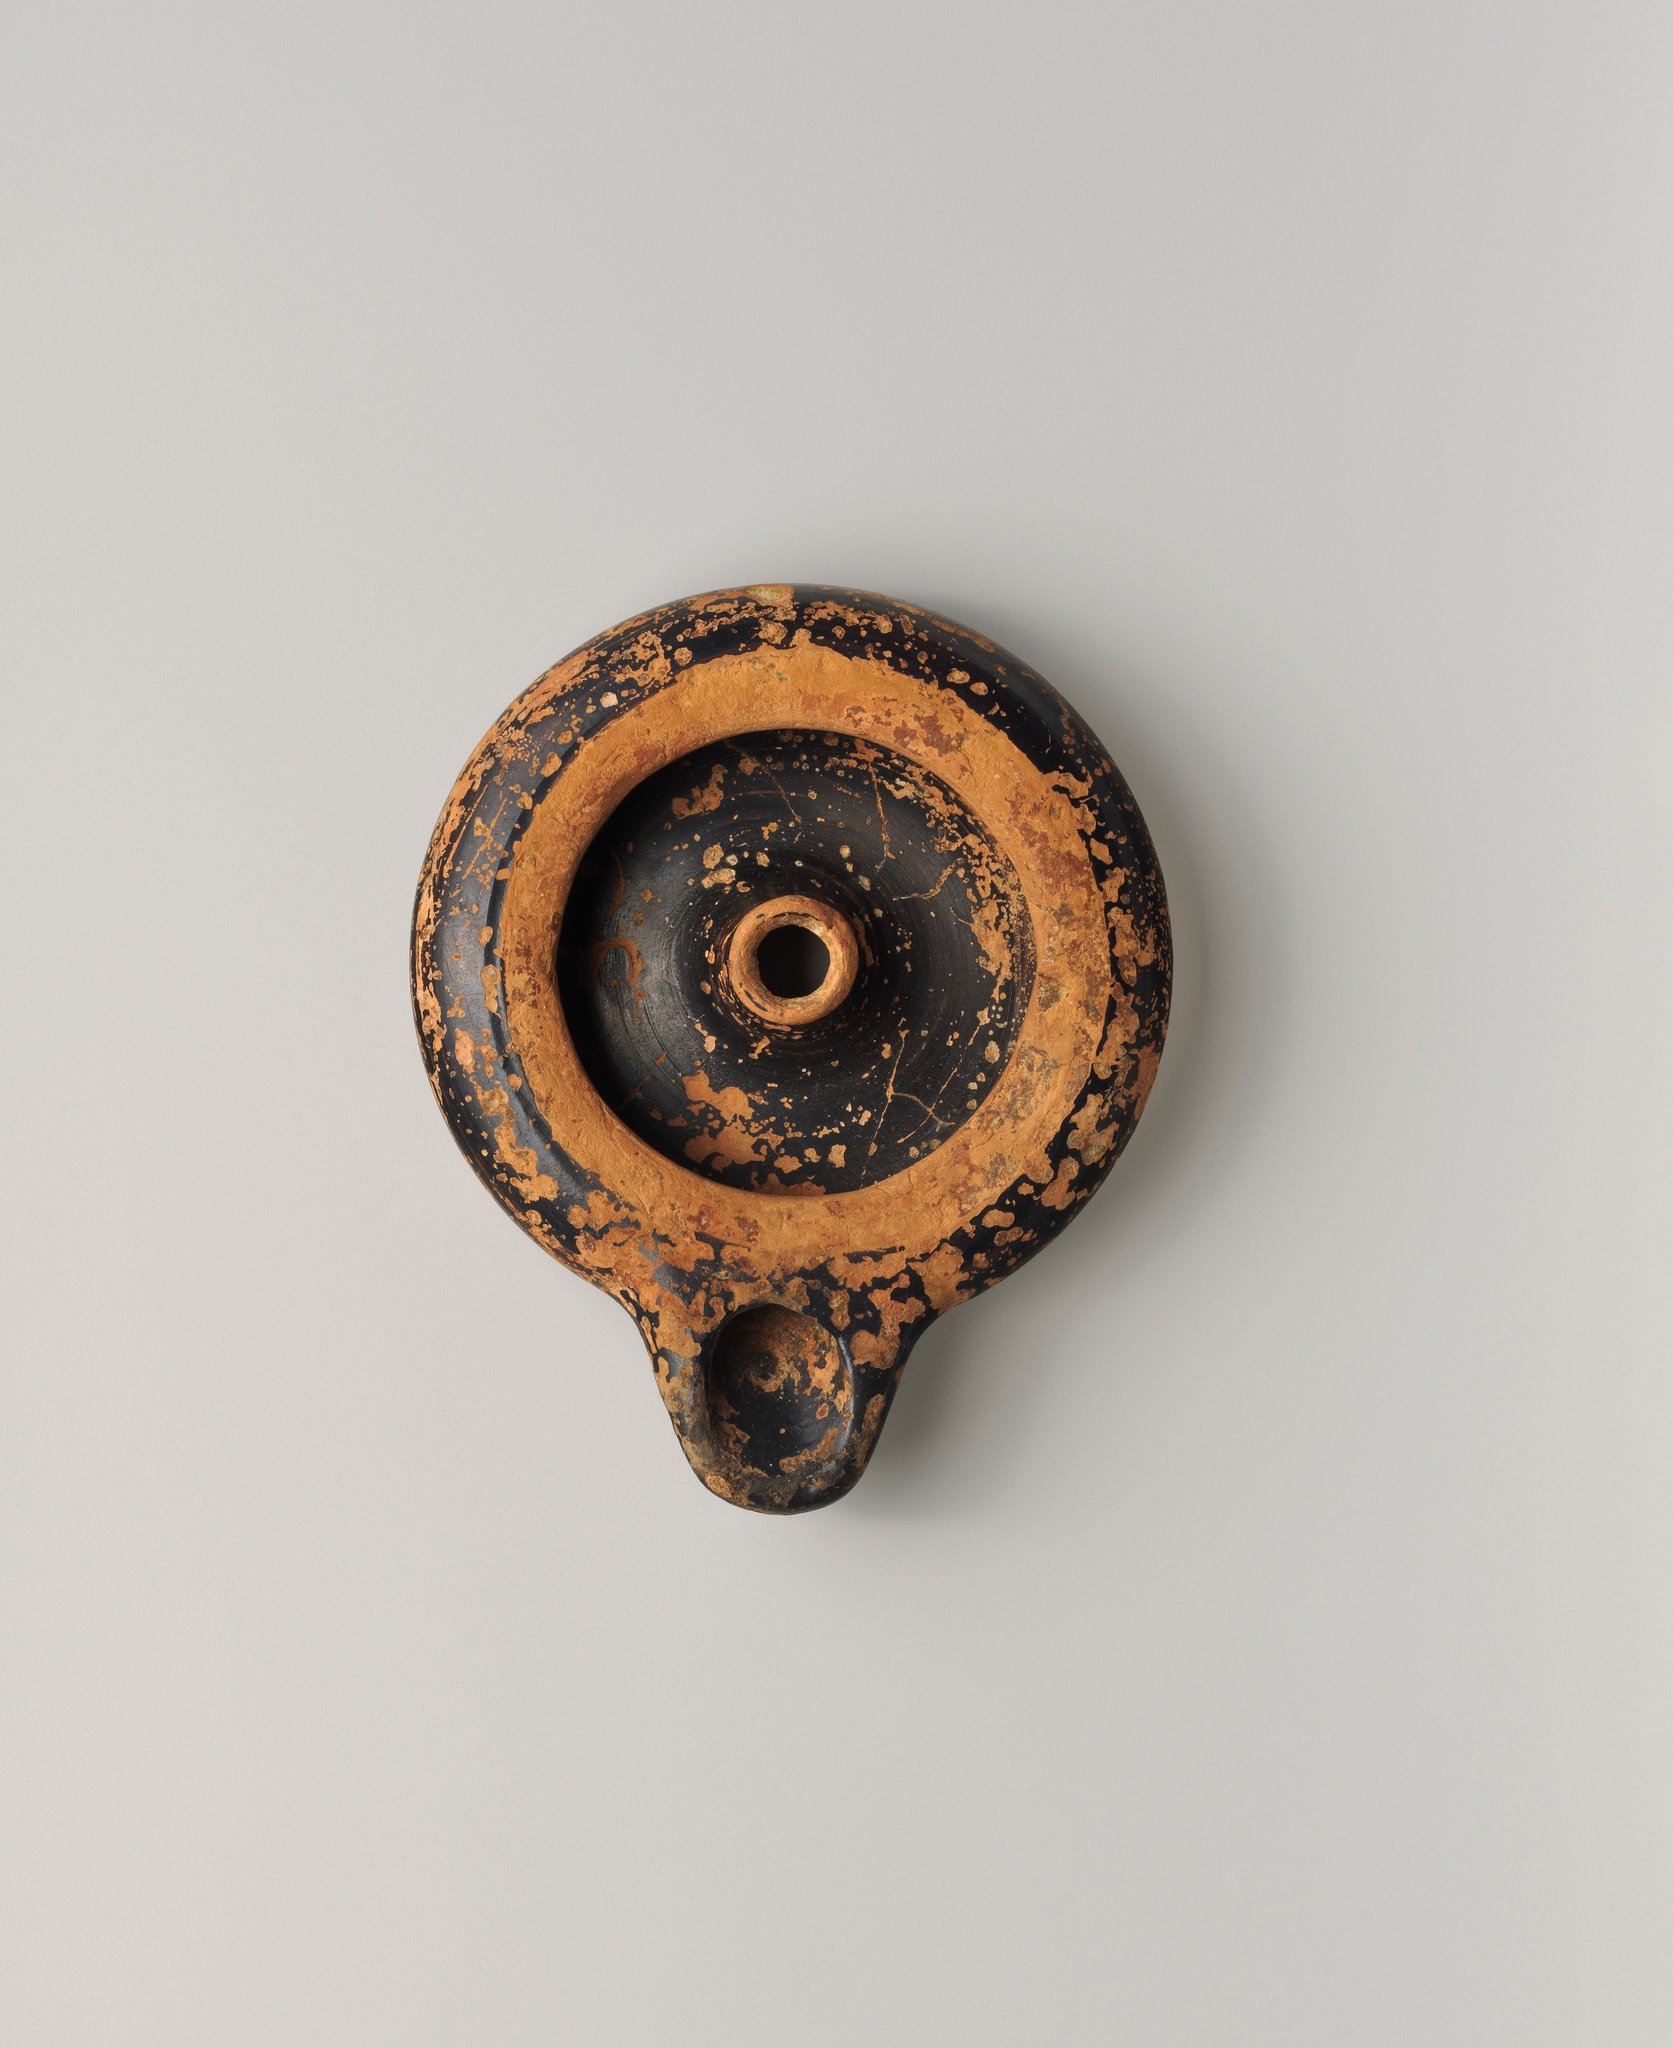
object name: lamp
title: Terracotta oil lamp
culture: greek, attic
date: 500-401 BCE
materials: terracotta